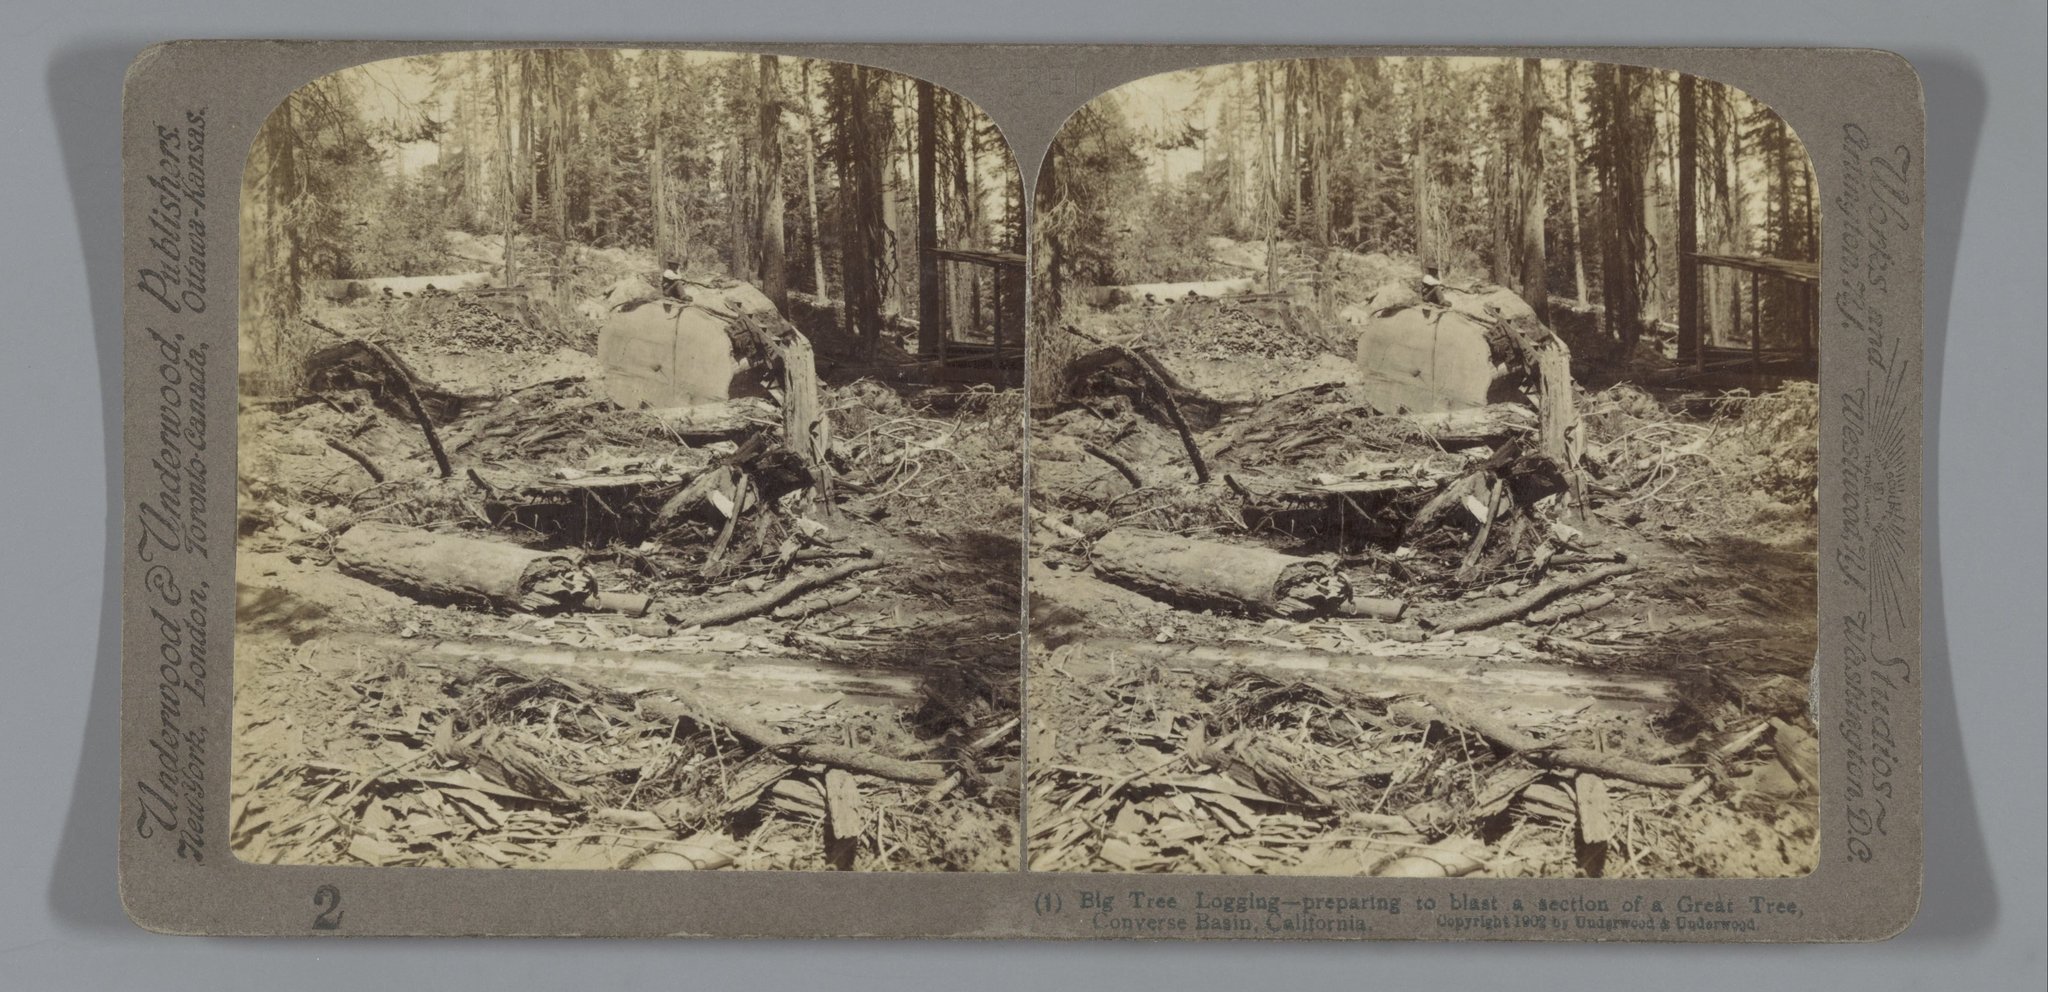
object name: stereograph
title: Big Tree Logging-preparing to blast a section of a Great Tree, Converse Basin, California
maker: Anonymous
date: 1902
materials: cardboard, paper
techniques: albumen print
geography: sierra nevada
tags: beam, log of wood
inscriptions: check stamp: ‘(ENERET)’, copyright notice: ‘Copyright 1902 by Underwood & Underwood.’, inscription: ‘We are near Millwood in Fresno County, 190/ miles southeast from San Francisco. The big/ trees of the famous (...)’, inscription: ‘SUN SCULPTURE/ UU/ TRADEMARK/ Works and Studios/ Arlington, N.J. Westwood, N.J. Washington, D.C.’, title: ‘Big Tree Logging. Preparing to Blast a Tree. California.’, number: ‘P. 54.’, number: ‘2’, number: ‘1’